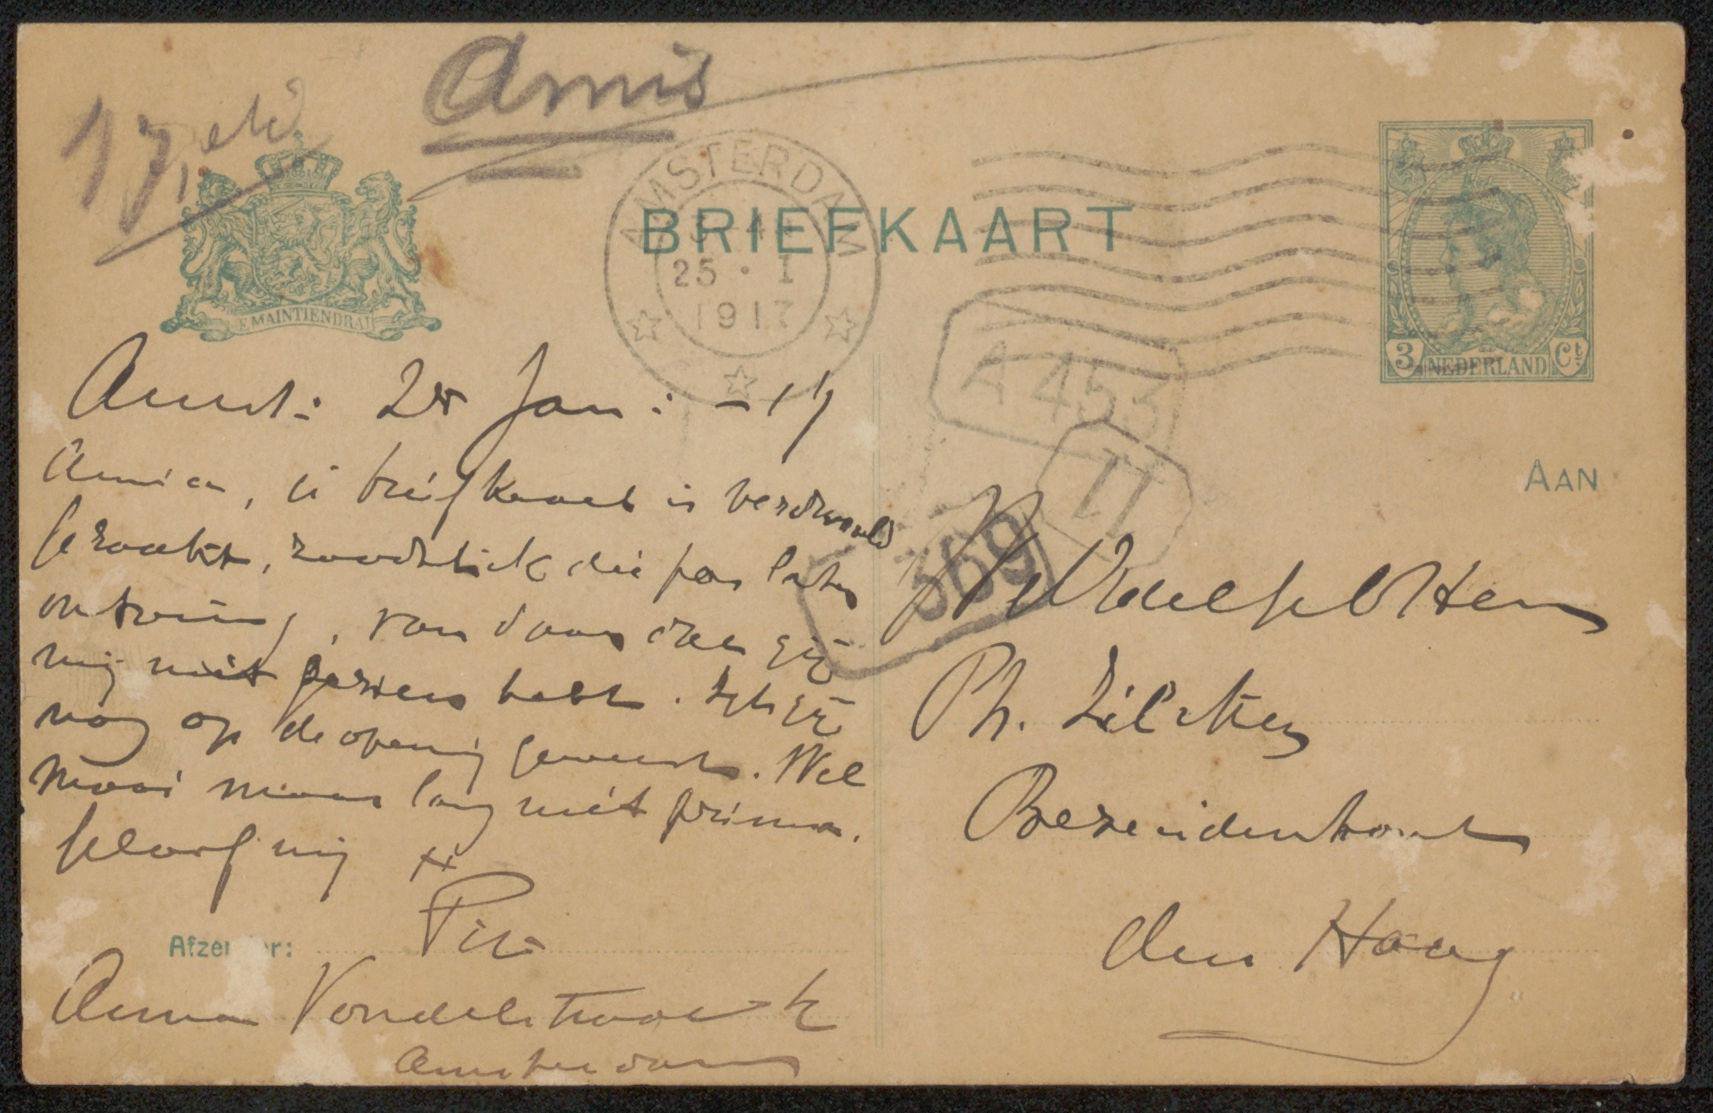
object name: postcard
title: Briefkaart aan Philip Zilcken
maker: adriaan pit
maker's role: print maker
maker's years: 1860-1944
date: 1917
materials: cardboard, ink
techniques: pen, writing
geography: amsterdam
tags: the hague, painter, draughtsman, philip zilcken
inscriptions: collector's mark: ‘RPK’